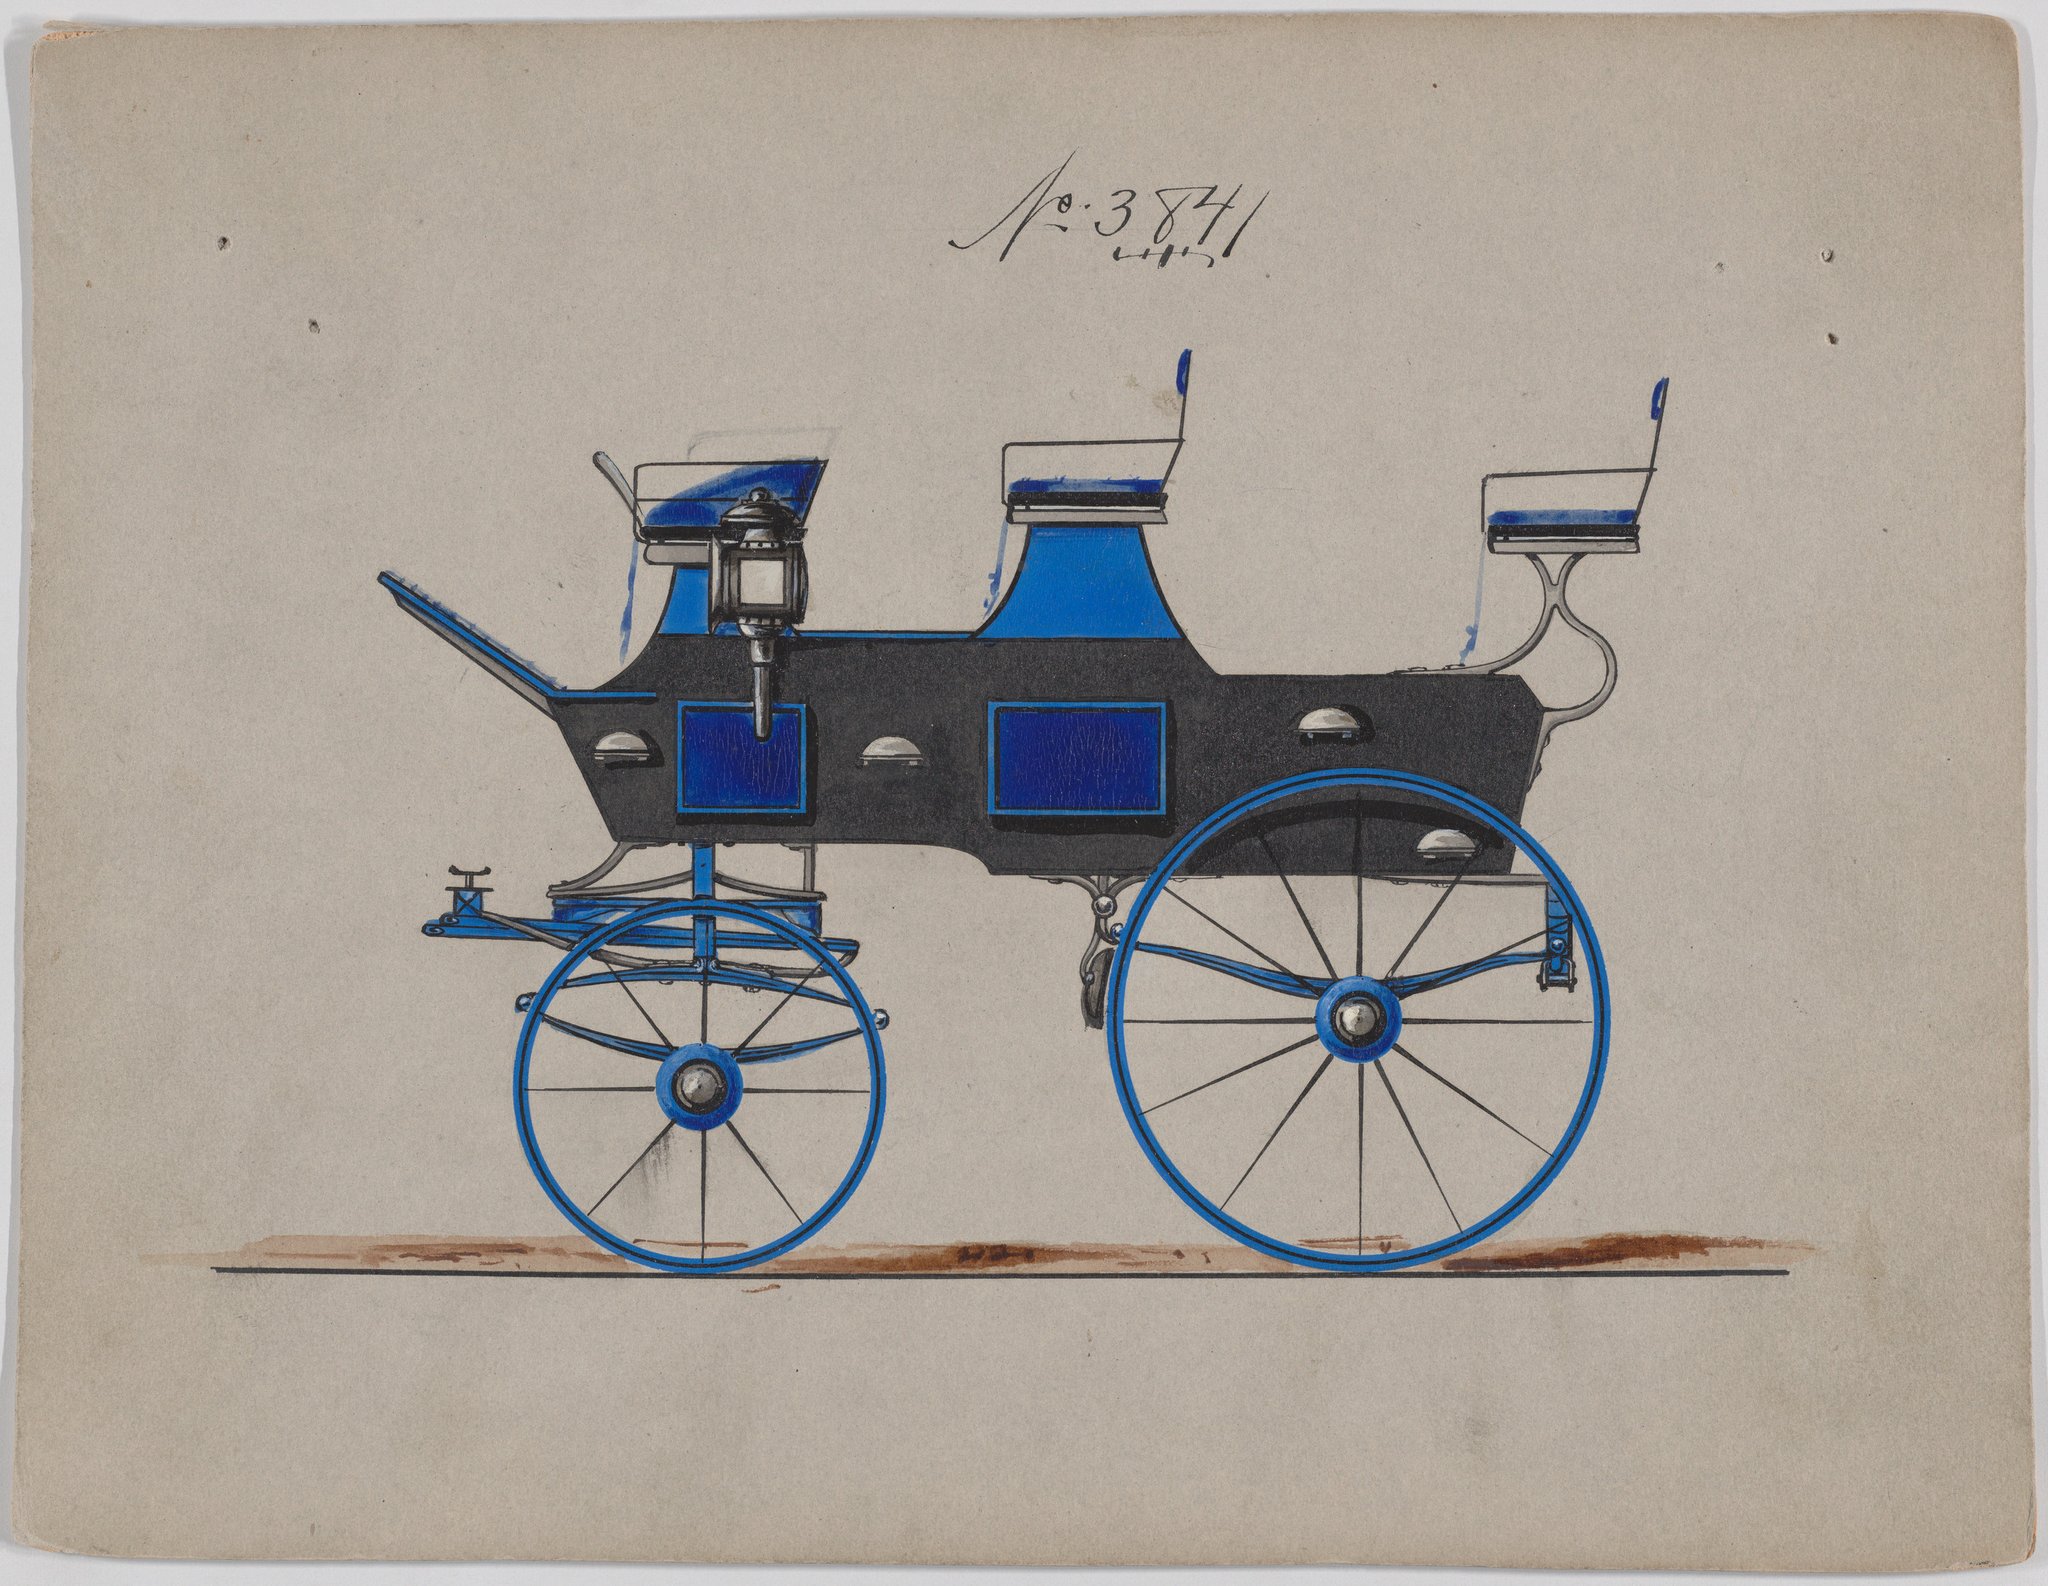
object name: drawing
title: Roof Seat Break #3841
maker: brewster & co.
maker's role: manufacturer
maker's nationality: american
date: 1883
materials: gouache, graphite, gum arabic, ink, watercolor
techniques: pen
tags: carriages